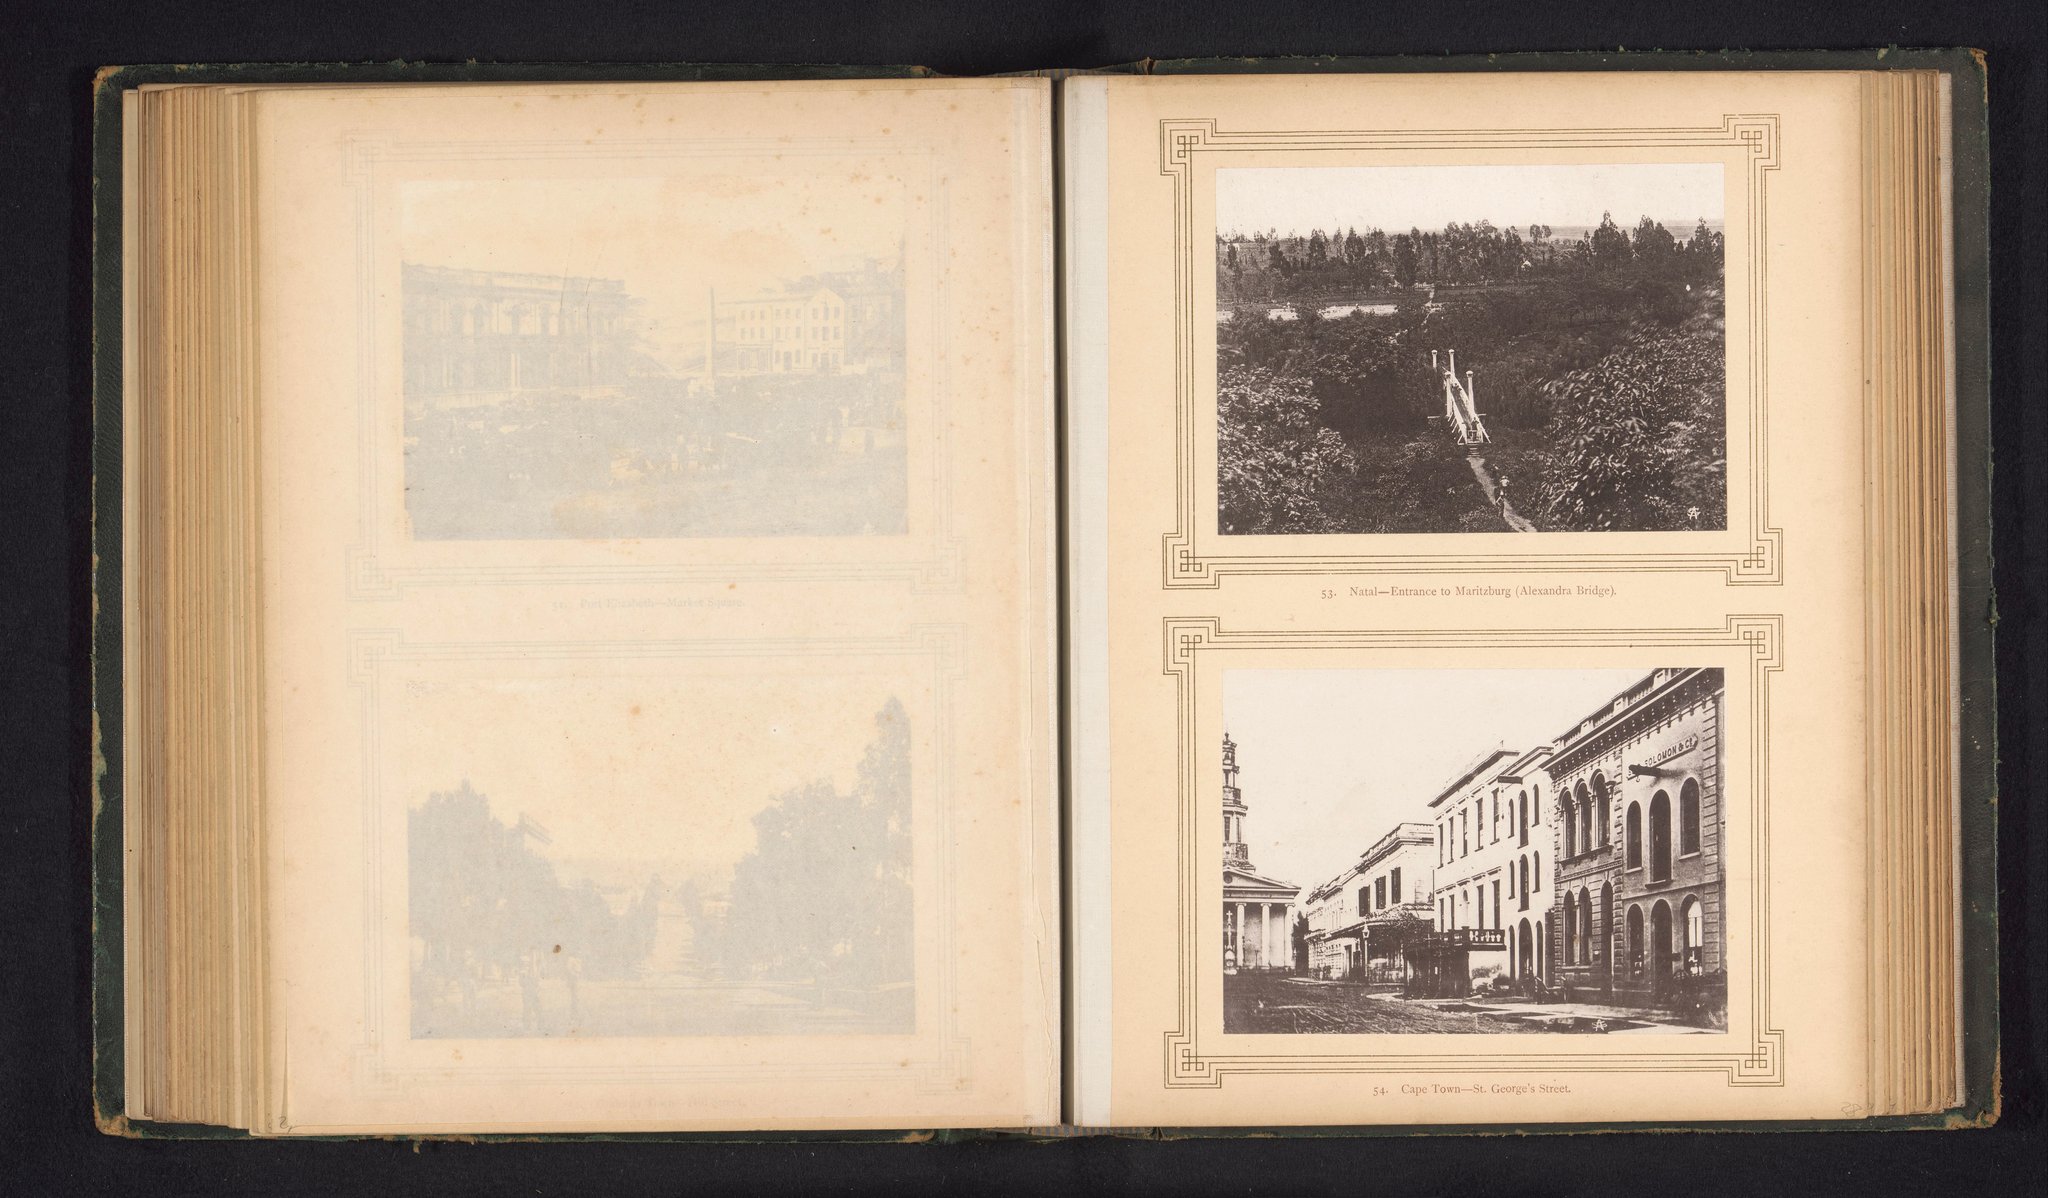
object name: page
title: Natal-Entrance to Maritzburg (Alexandra Bridge)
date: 1870-1880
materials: paper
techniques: photograph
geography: south africa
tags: landscape with bridge, viaduct or aqueduct, façade (of house or building), street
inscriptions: number: ‘53. 54.’, inscription: ‘SA’